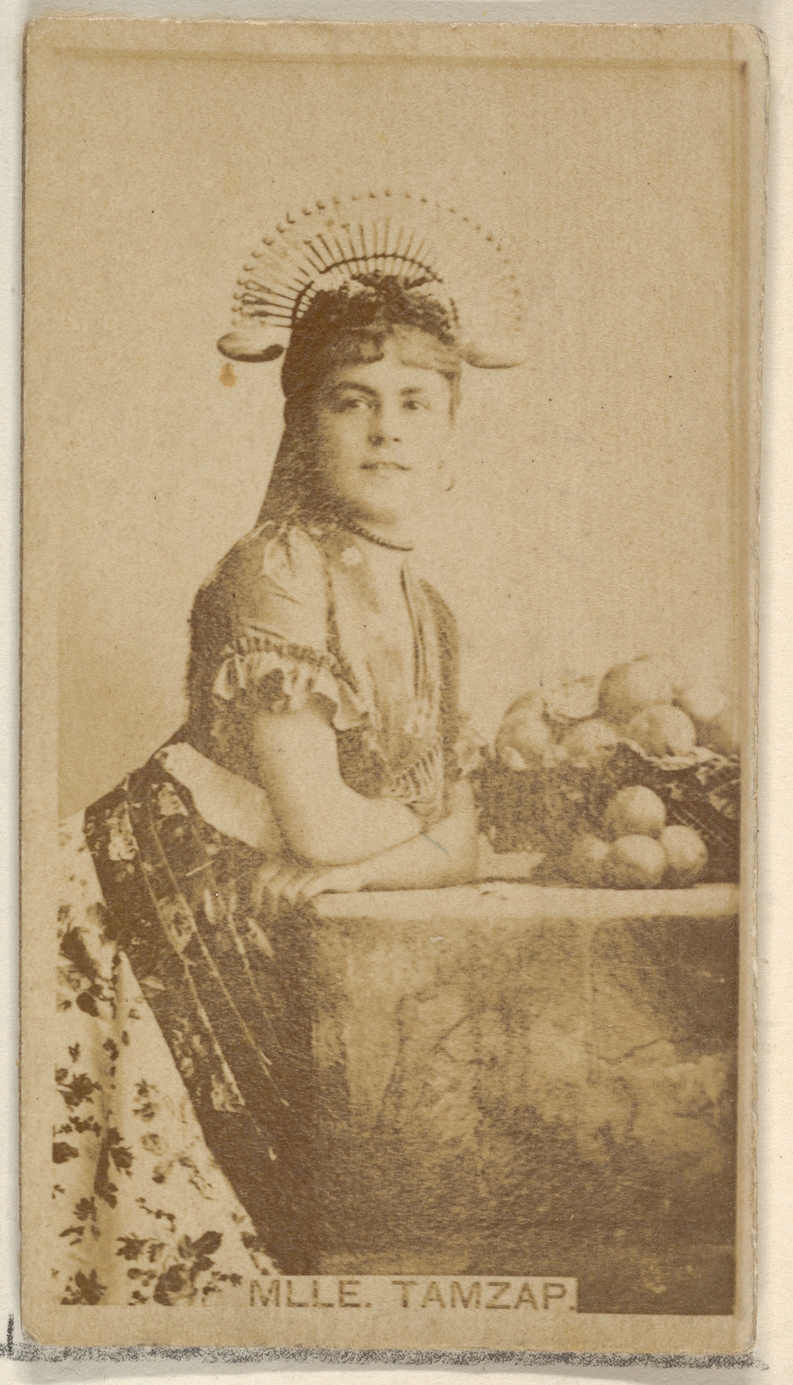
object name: photograph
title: Mlle. Tamzap, from the Actors and Actresses series (N45, Type 8) for Virginia Brights Cigarettes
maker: allen & ginter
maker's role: publisher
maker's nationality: american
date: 1888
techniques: albumen silver print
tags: portraits,women,actresses